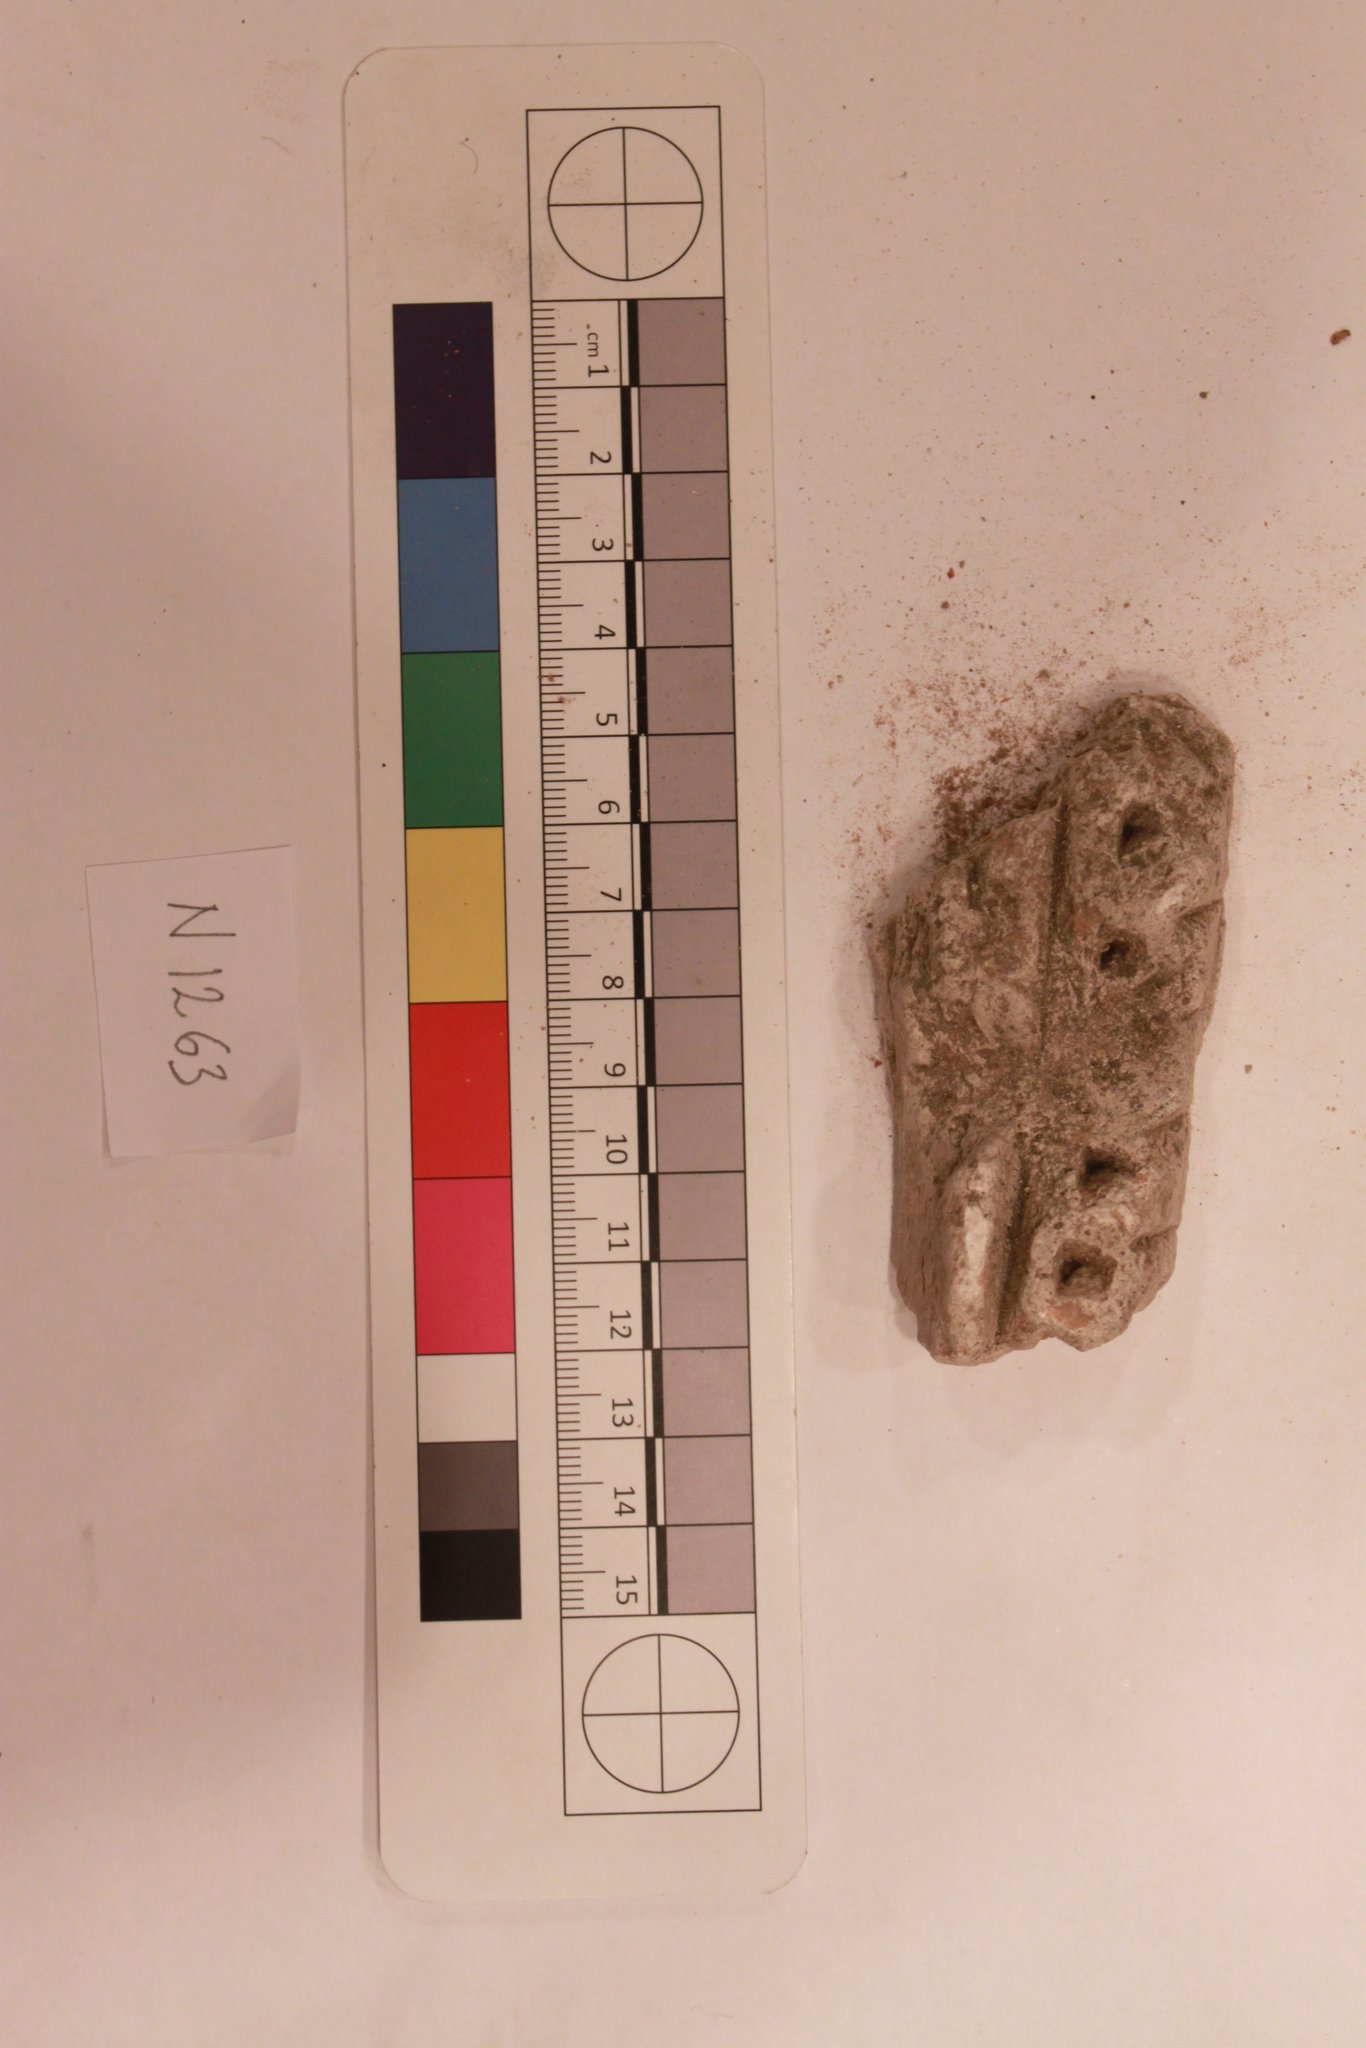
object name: fragment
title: Stucco Fragment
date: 701-1200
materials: plaster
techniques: carving, painting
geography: iran